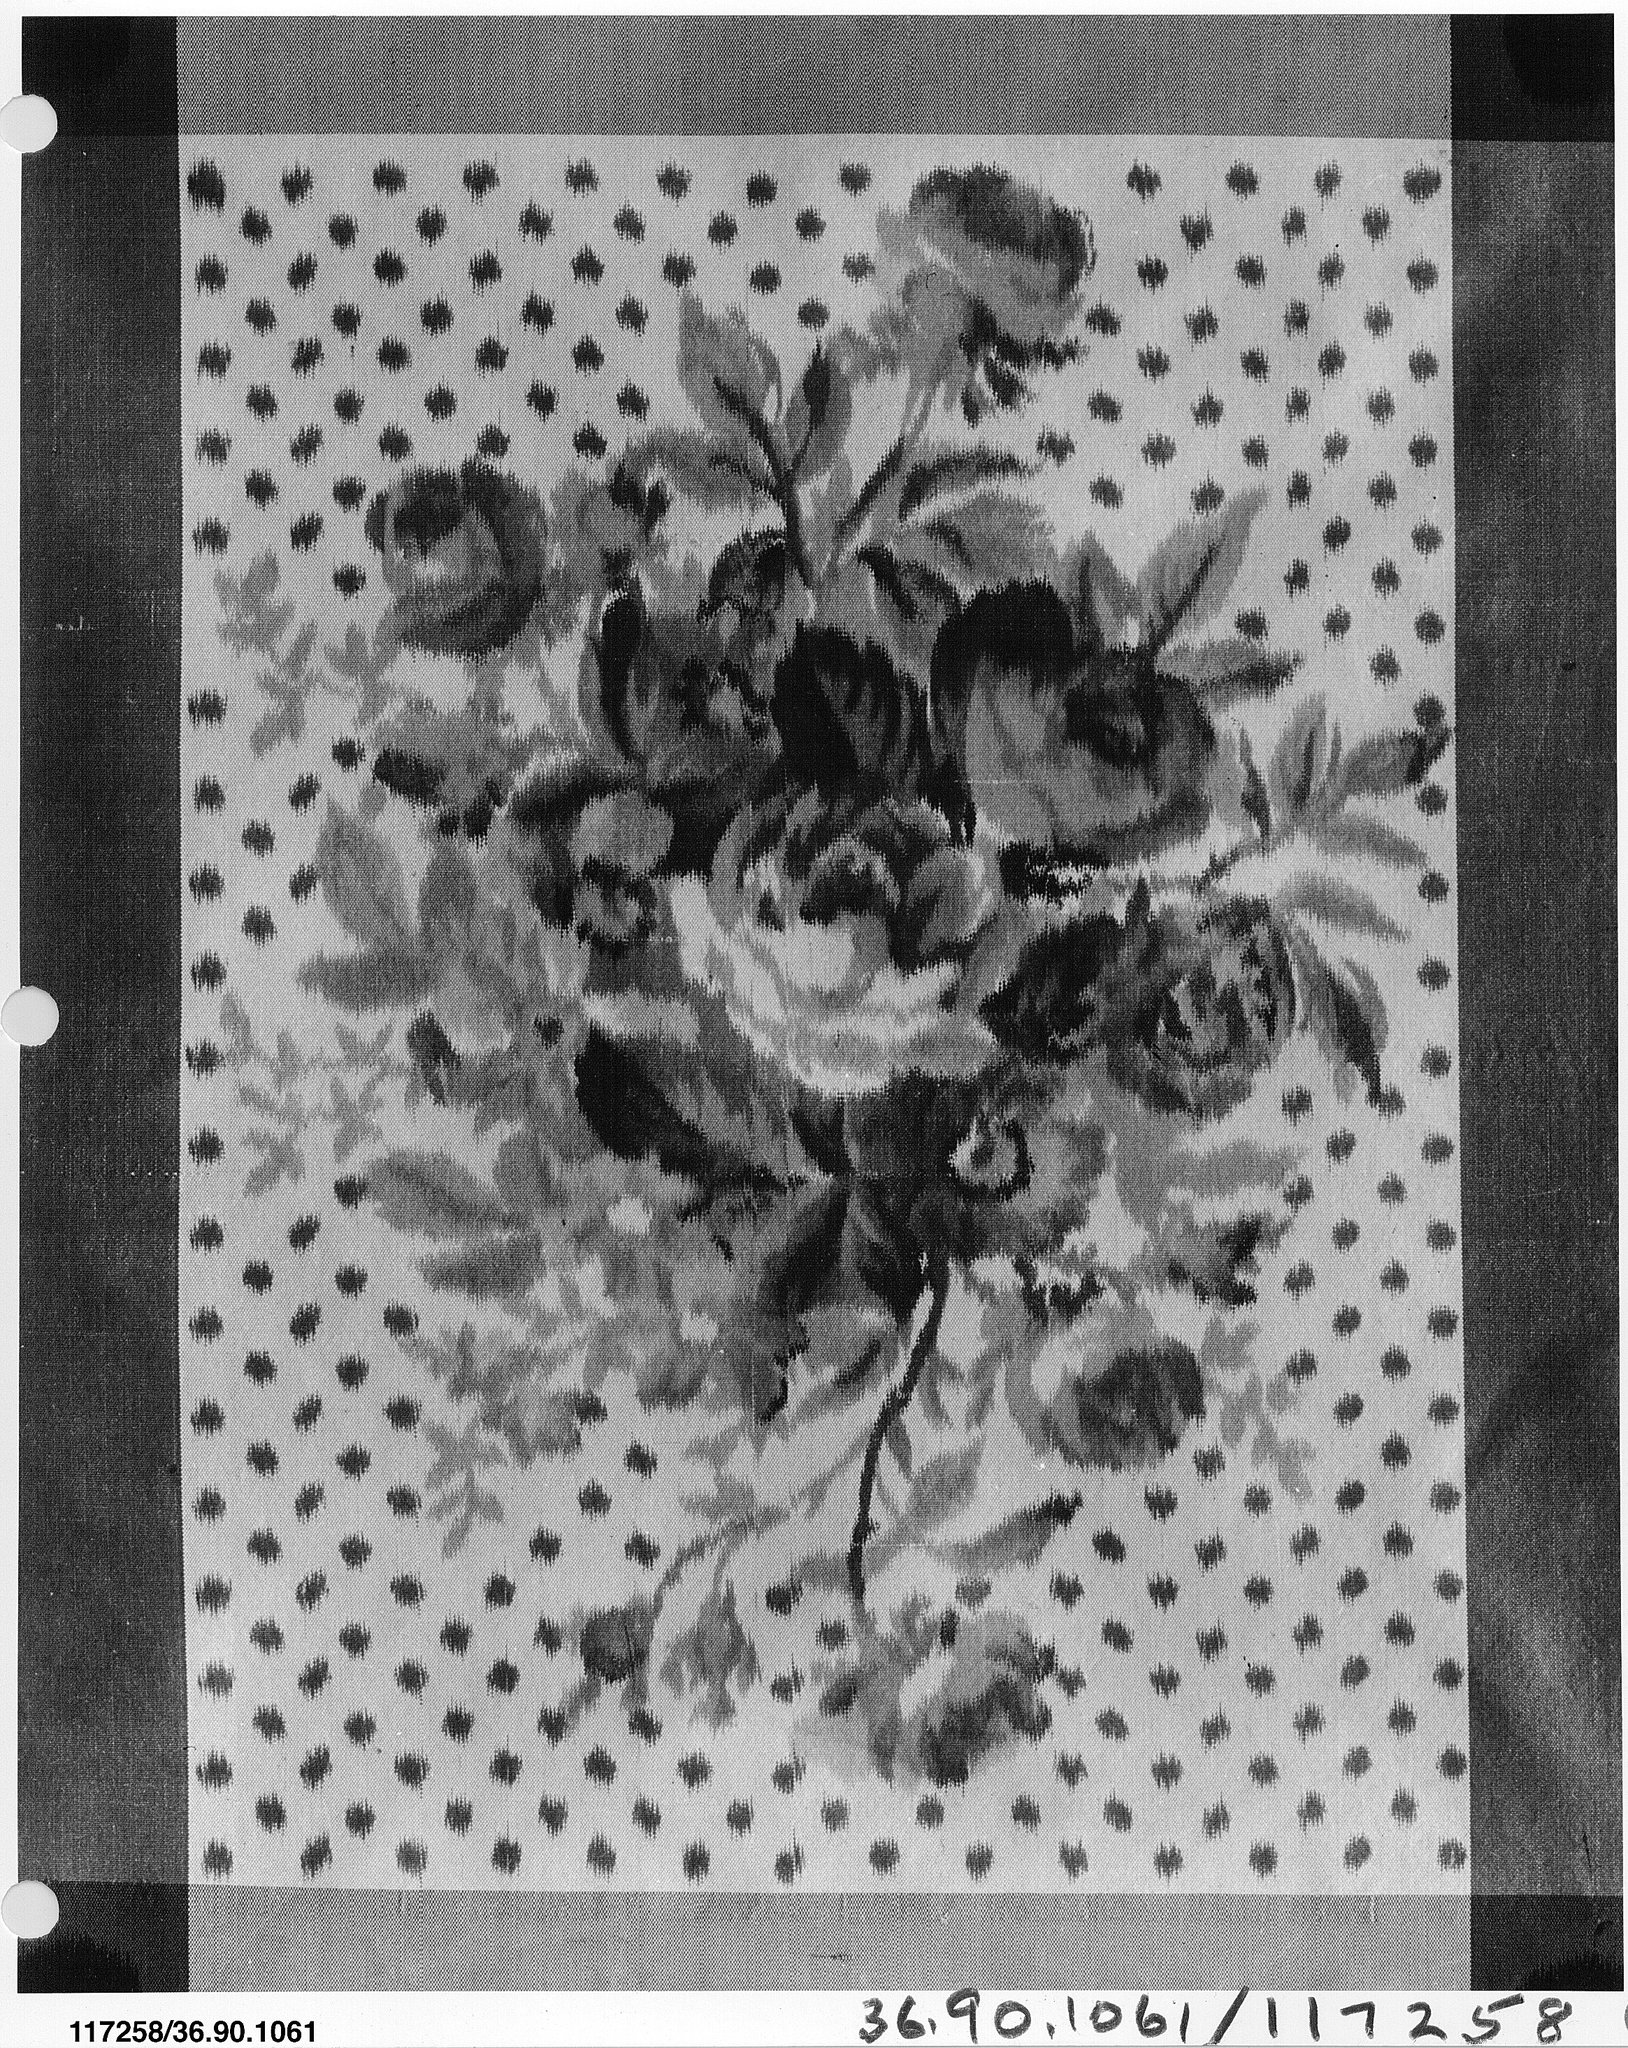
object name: piece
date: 1867-1900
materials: silk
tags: flowers,leaves